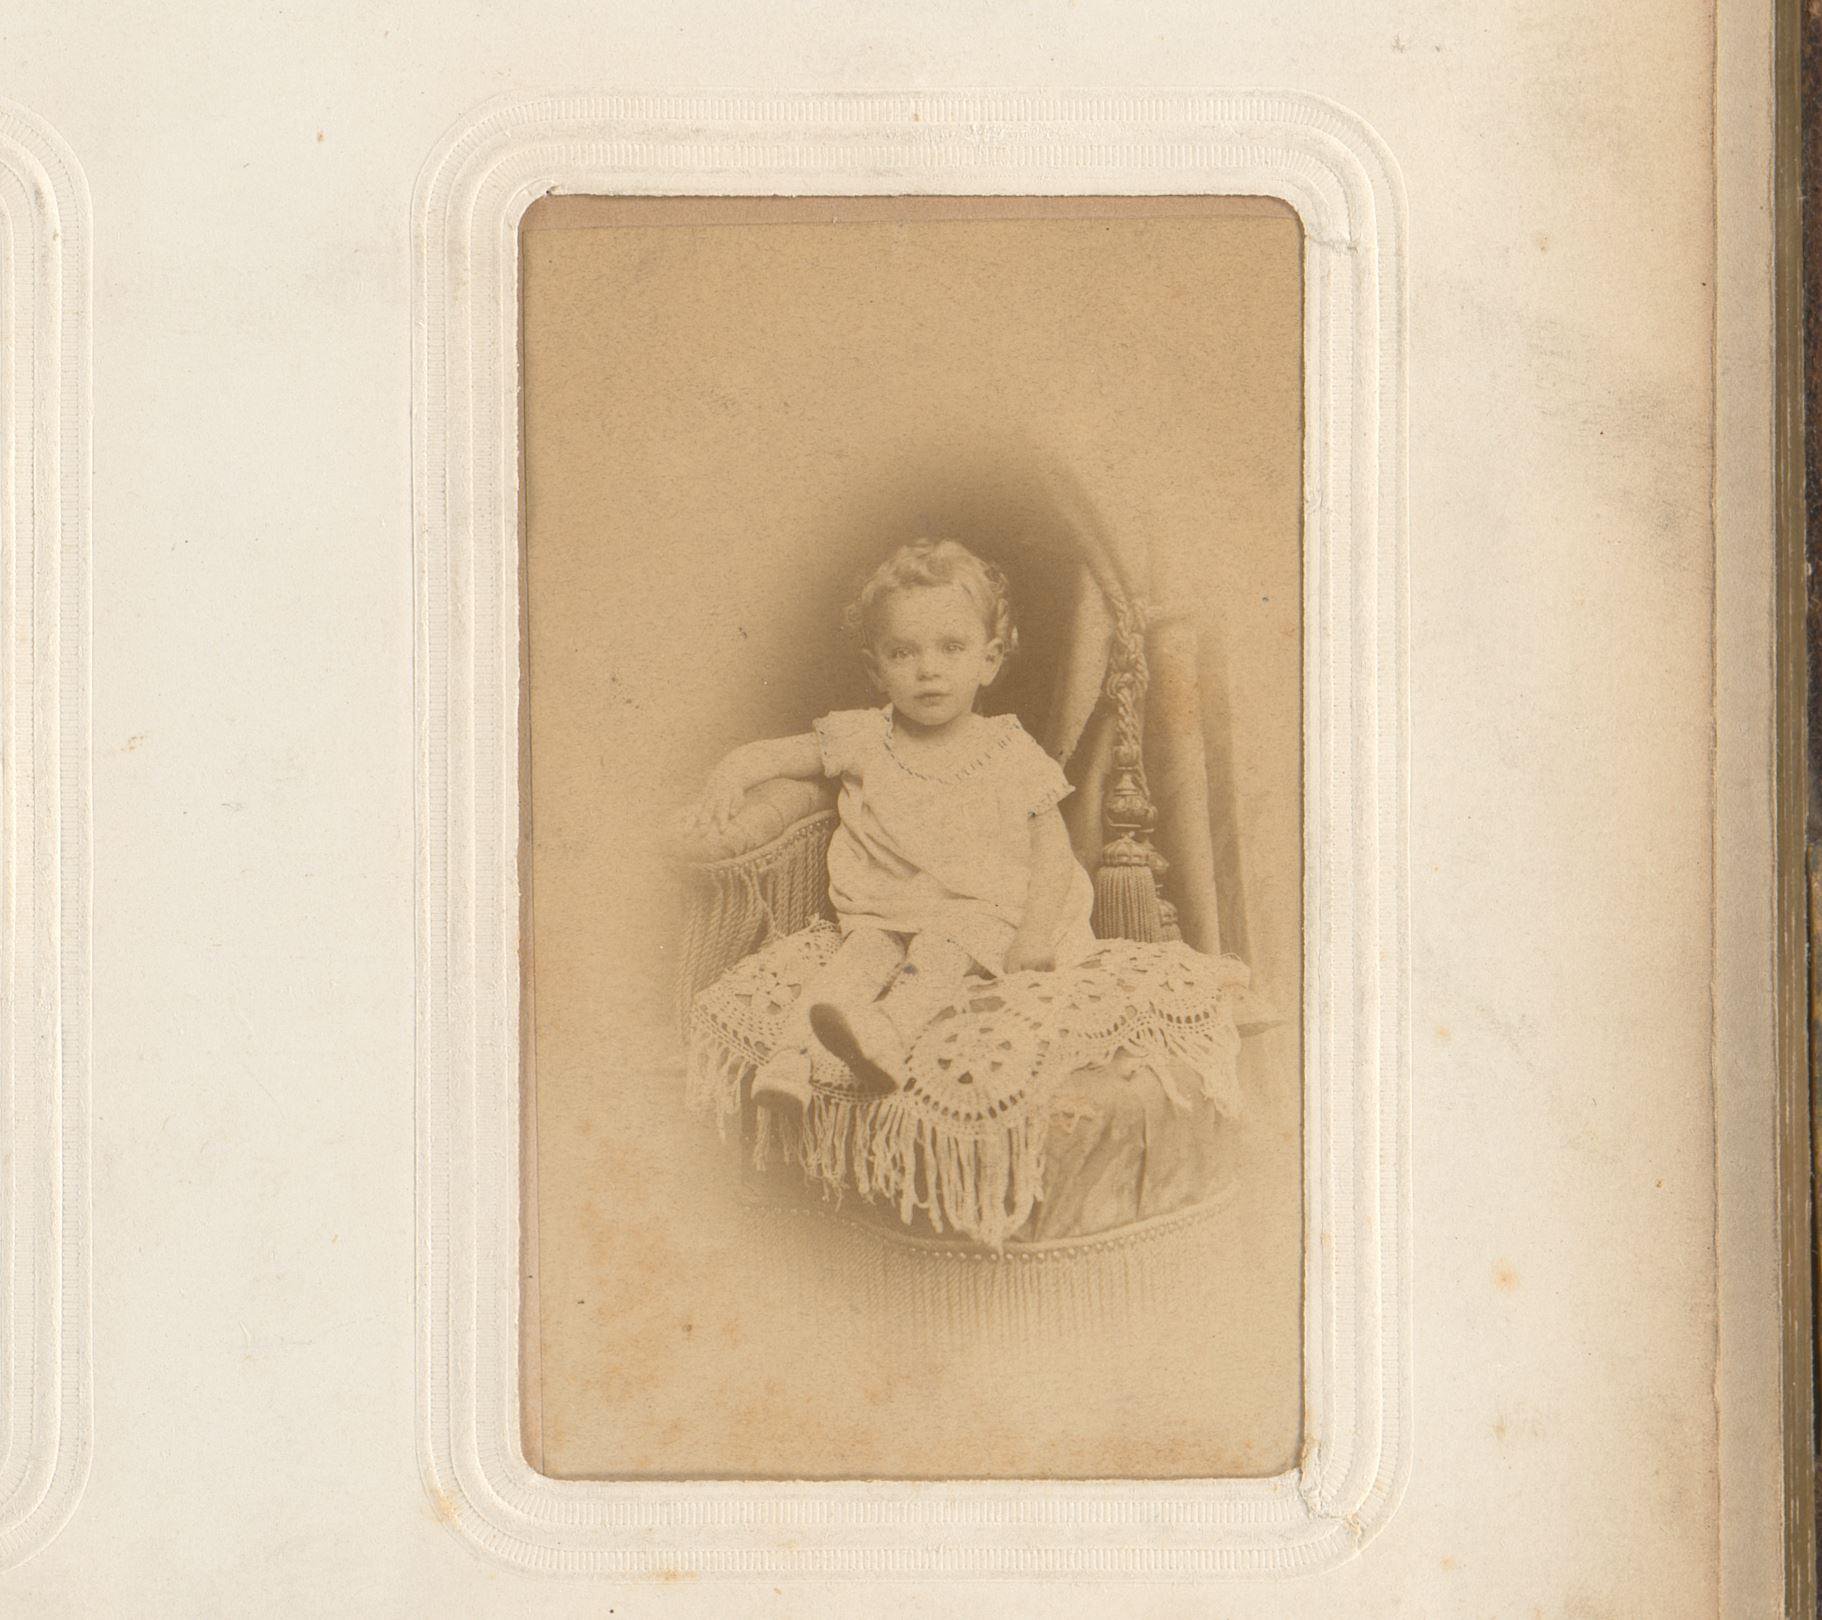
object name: album leaf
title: Portret van een kind, zittend op een stoel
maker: Anonymous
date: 1865-1900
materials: cardboard, paper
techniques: albumen print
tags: child, historical persons